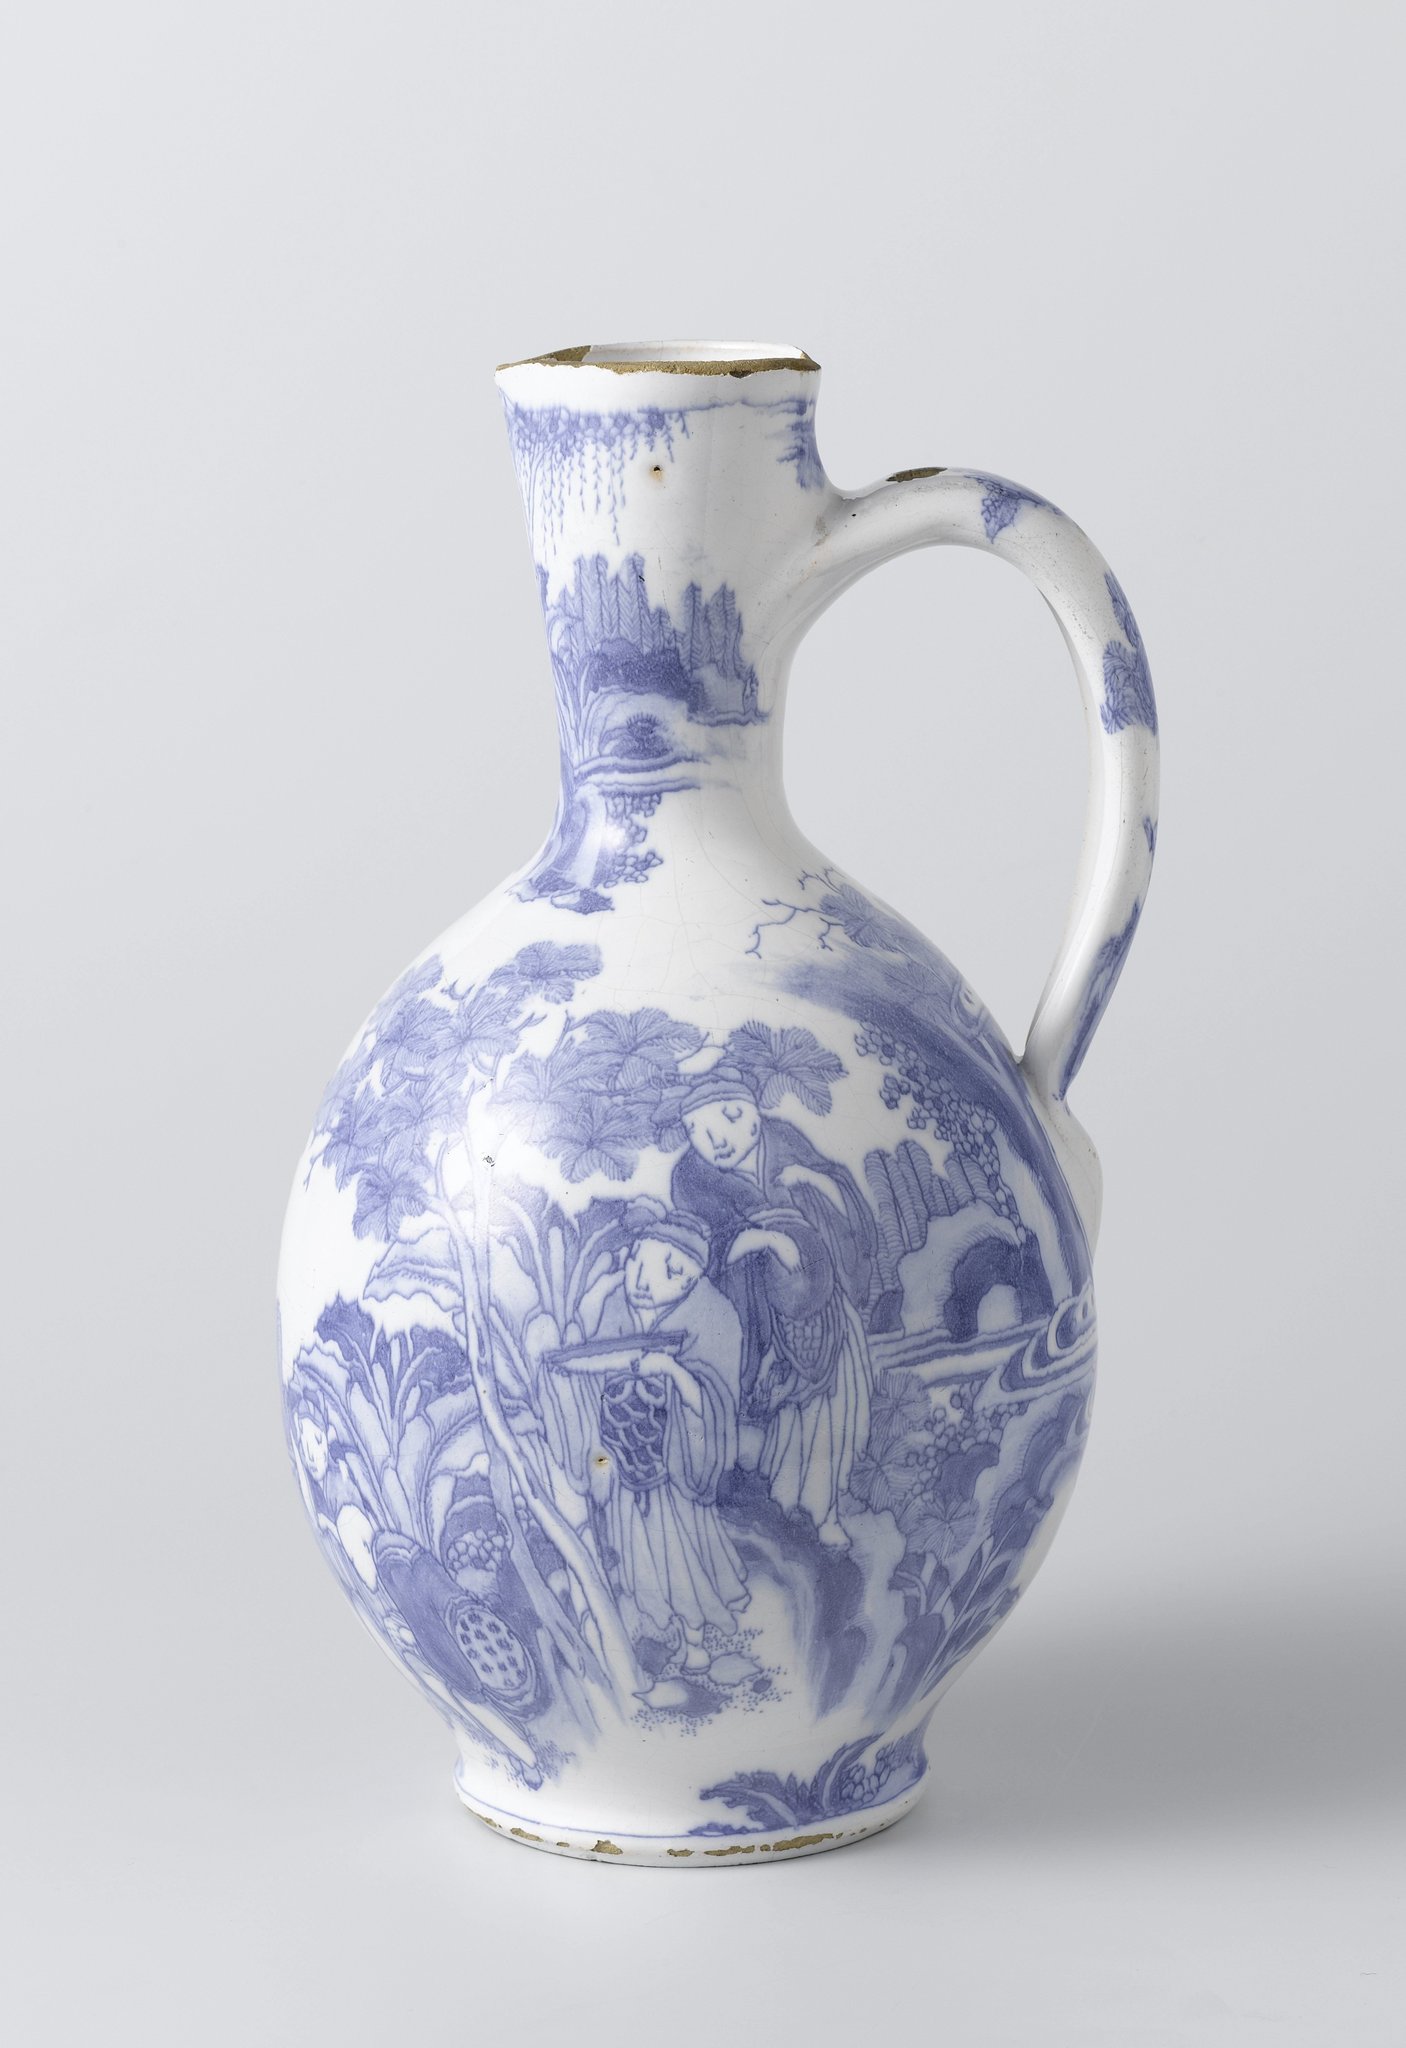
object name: ewer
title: Jug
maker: Anonymous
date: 1650-1675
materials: earthenware, glaze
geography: delft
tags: chinese (+ other cultural aspects)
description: Kan van faience met een decoratie naar het Chinese porselein uit de overgangsperiode